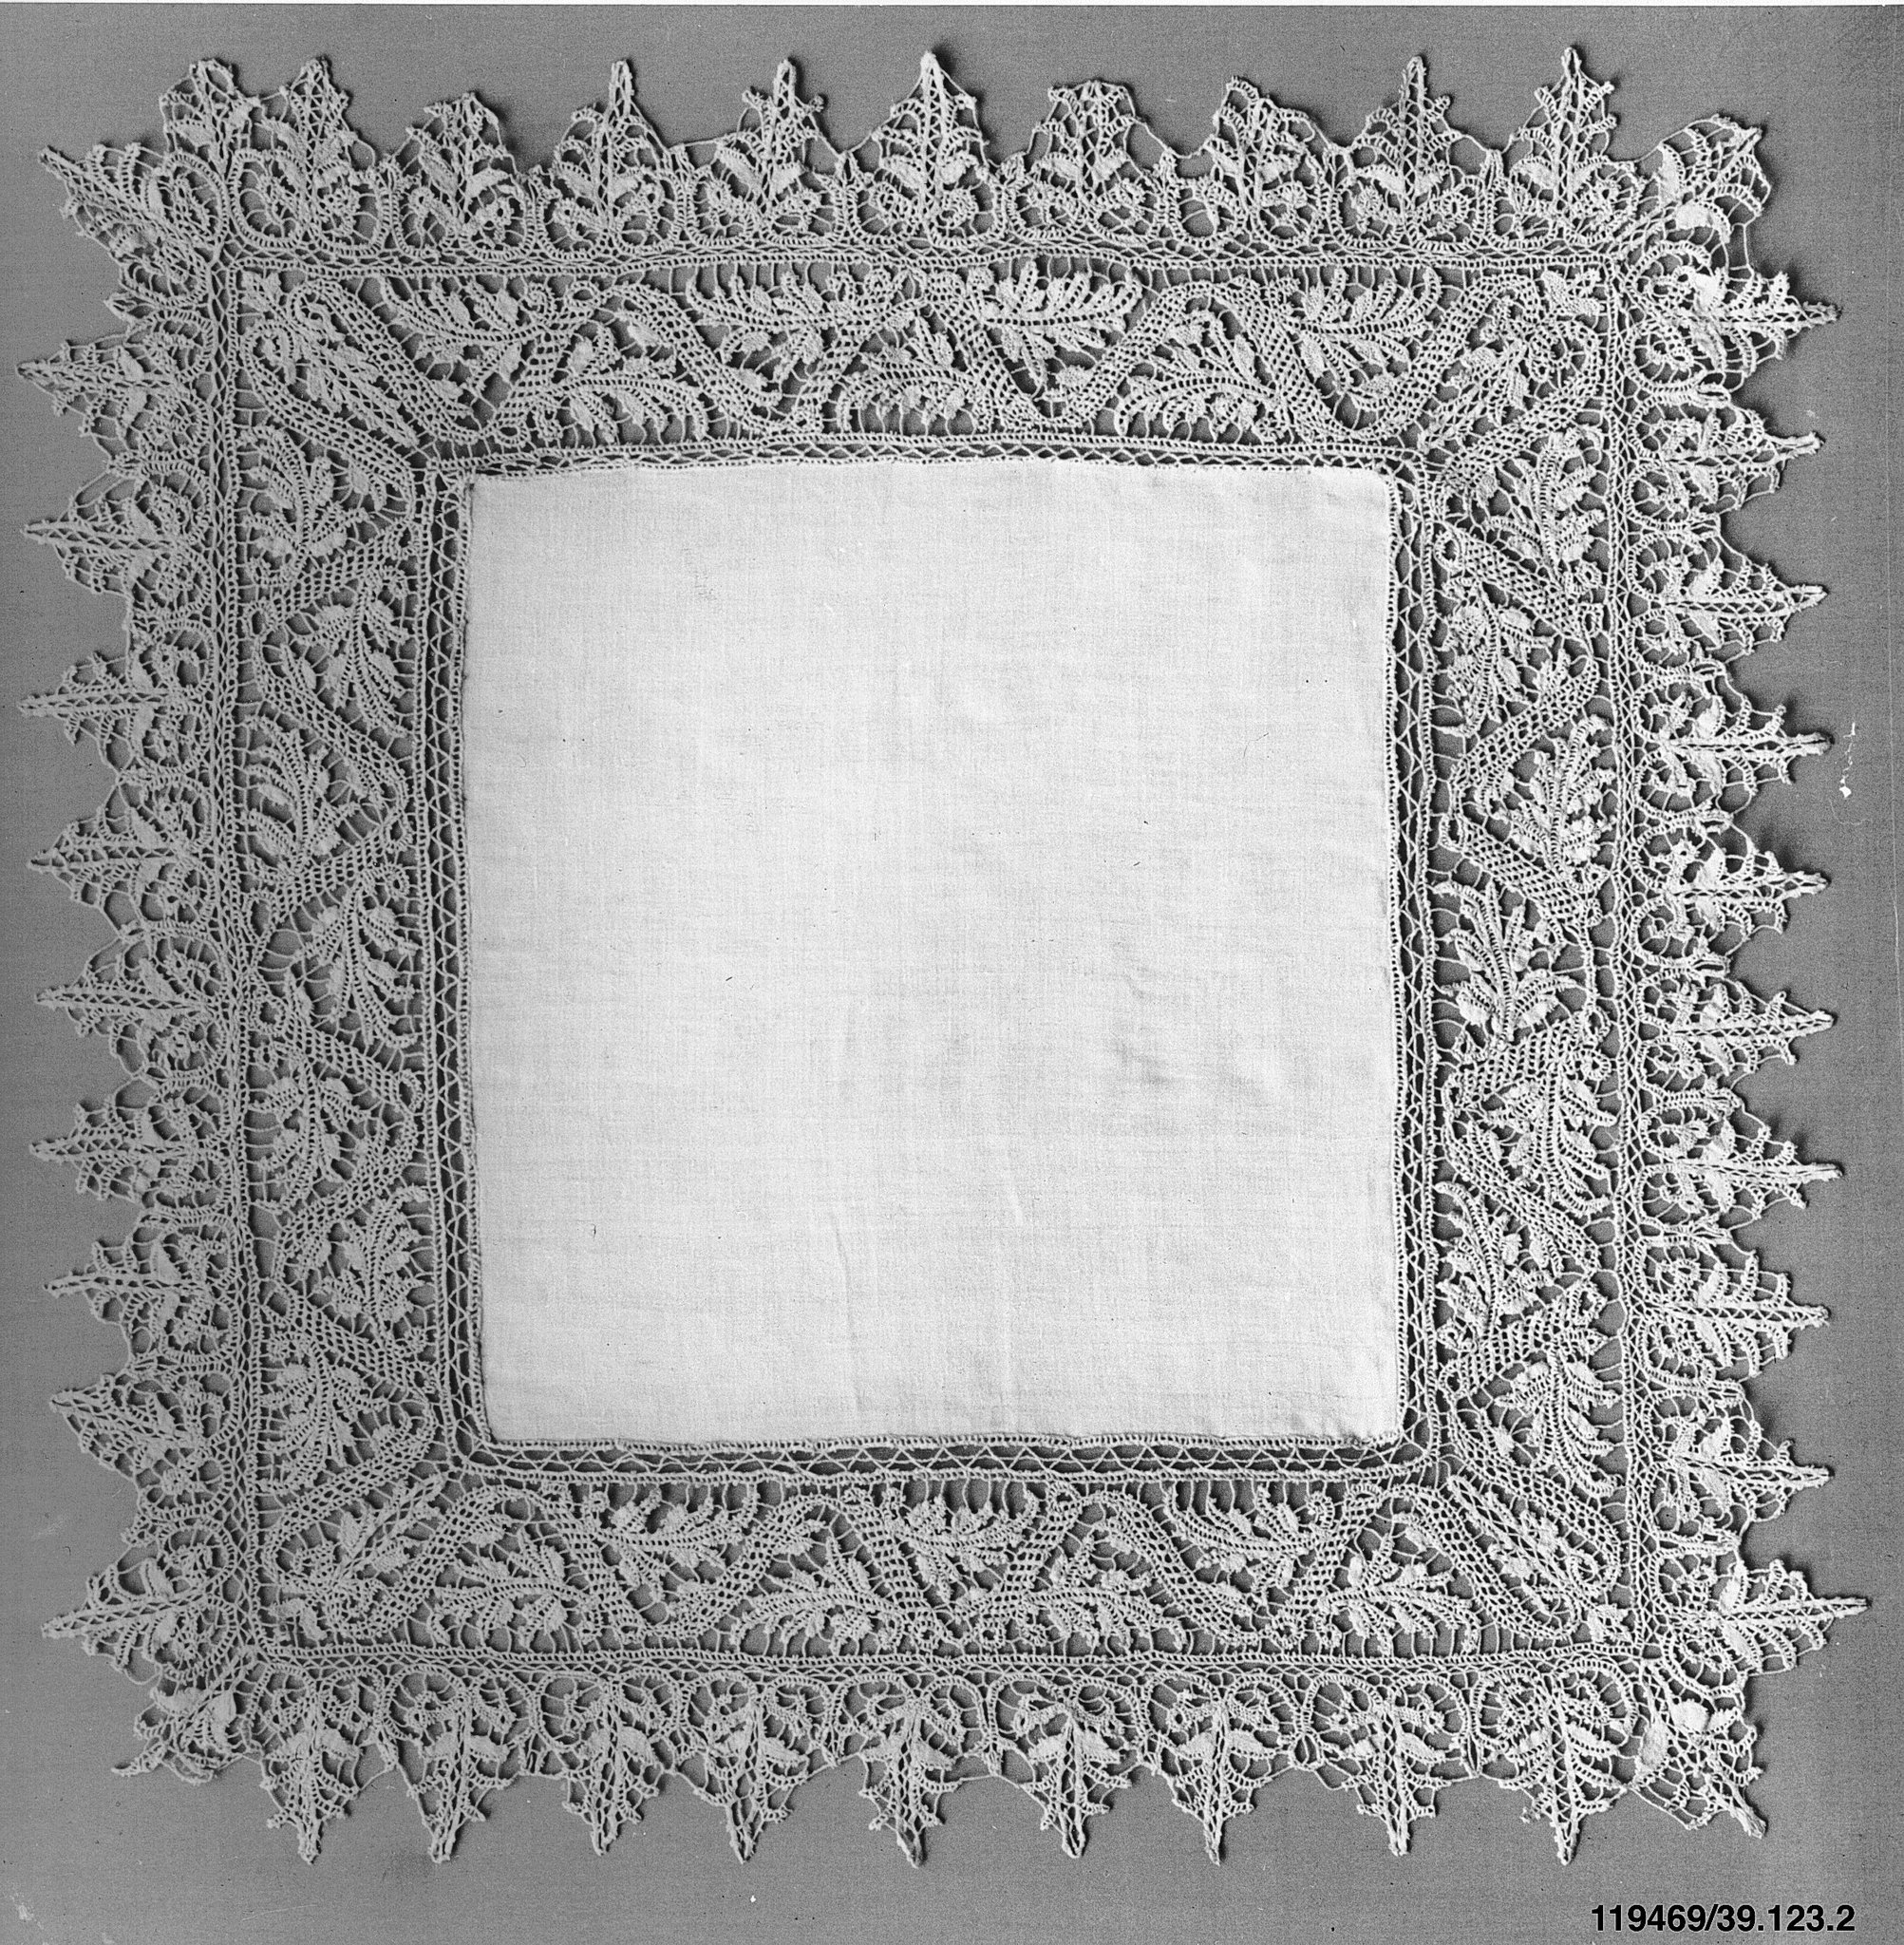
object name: cover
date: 1601-1700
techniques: lace